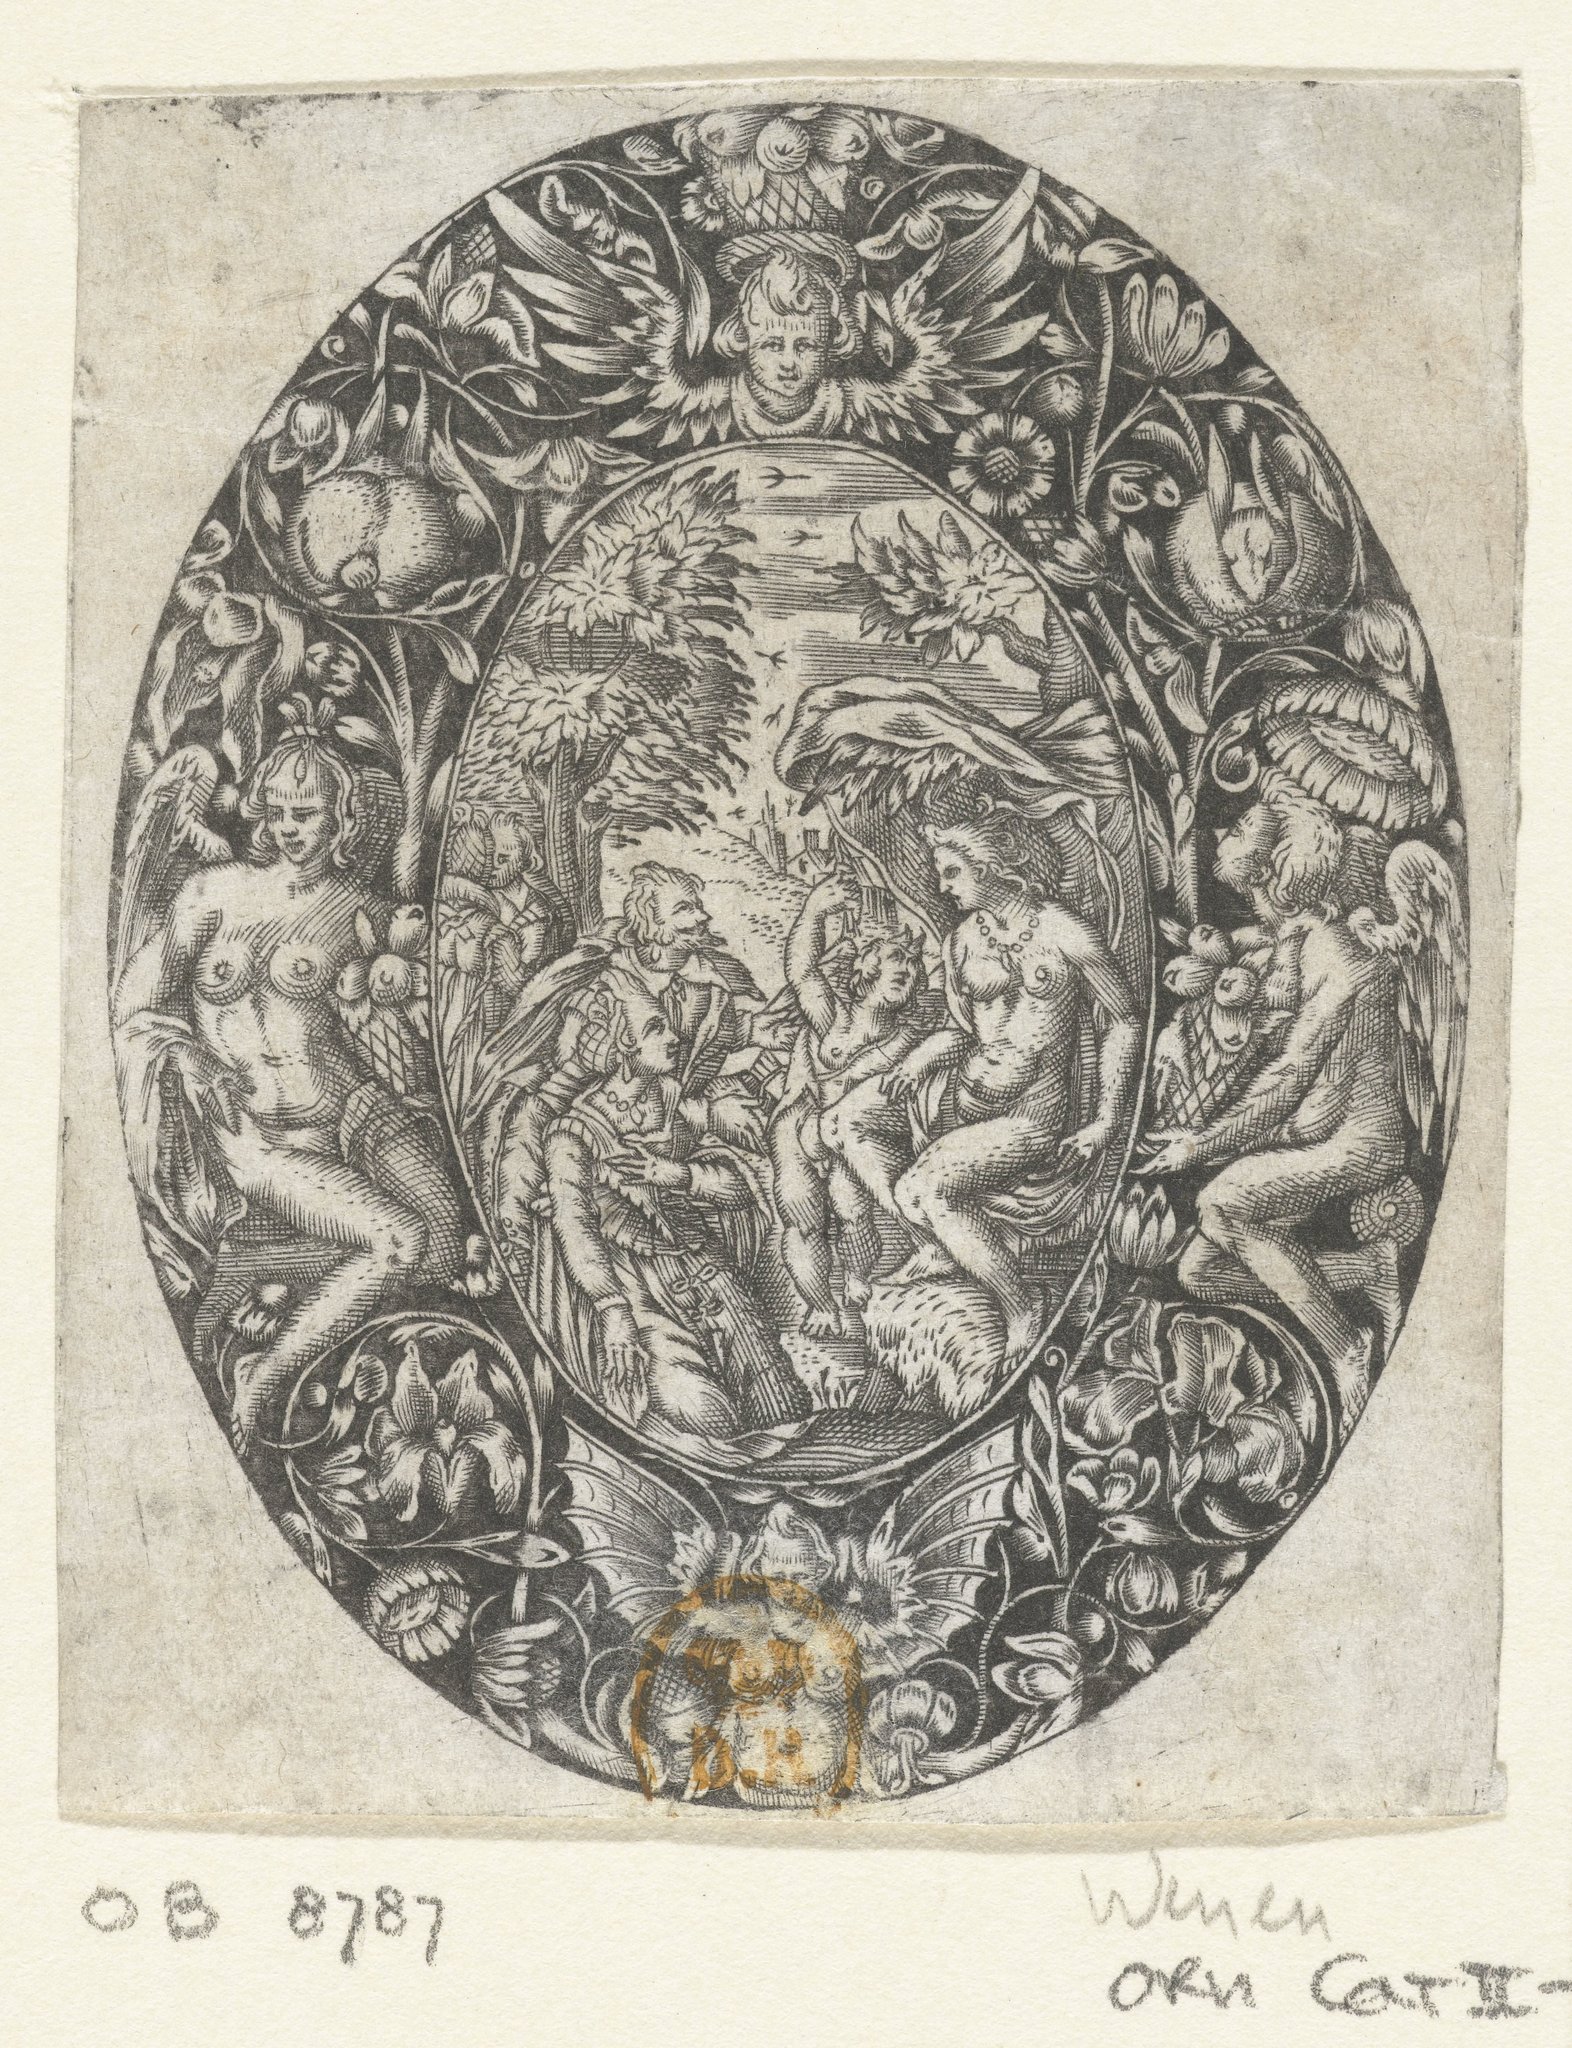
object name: ornament print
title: Ovaal met Venus en Amor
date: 1610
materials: paper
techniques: engraving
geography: amsterdam